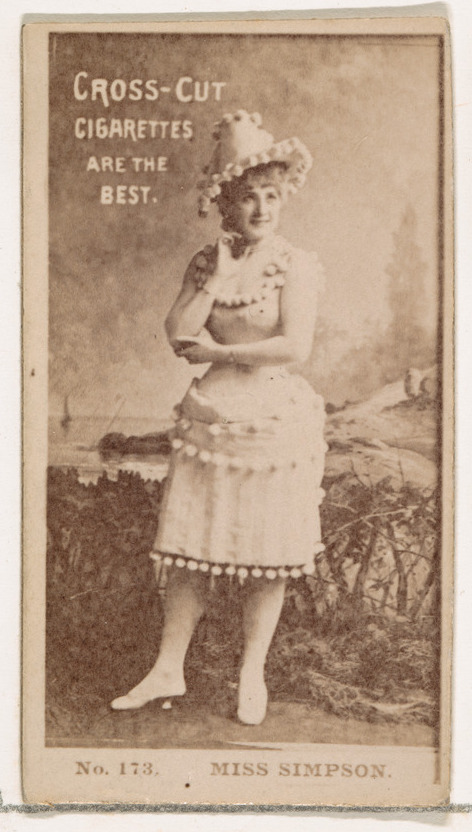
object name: print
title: Card Number 173, Miss Simpson, from the Actors and Actresses series (N145-2) issued by Duke Sons & Co. to promote Cross Cut Cigarettes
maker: w. duke, sons & co.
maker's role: publisher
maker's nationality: american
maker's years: 1870-1920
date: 1880-1889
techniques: albumen silver print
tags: portraits,women,actresses